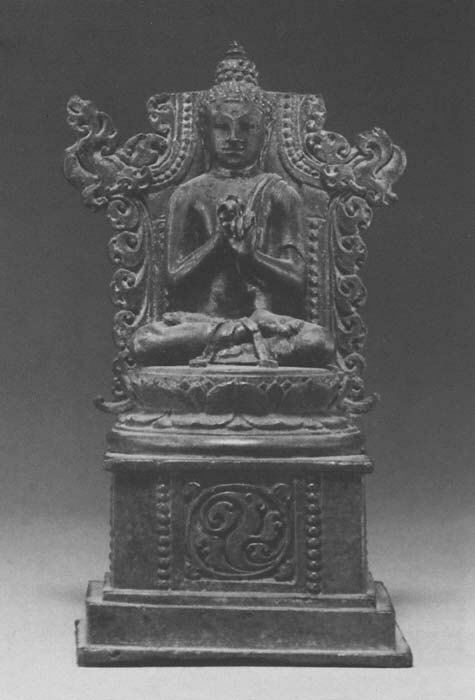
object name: figurine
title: Seated Transcendent Buddha Vairochana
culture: indonesian, javanese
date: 951-1000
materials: bronze, silver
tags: buddhism,buddha